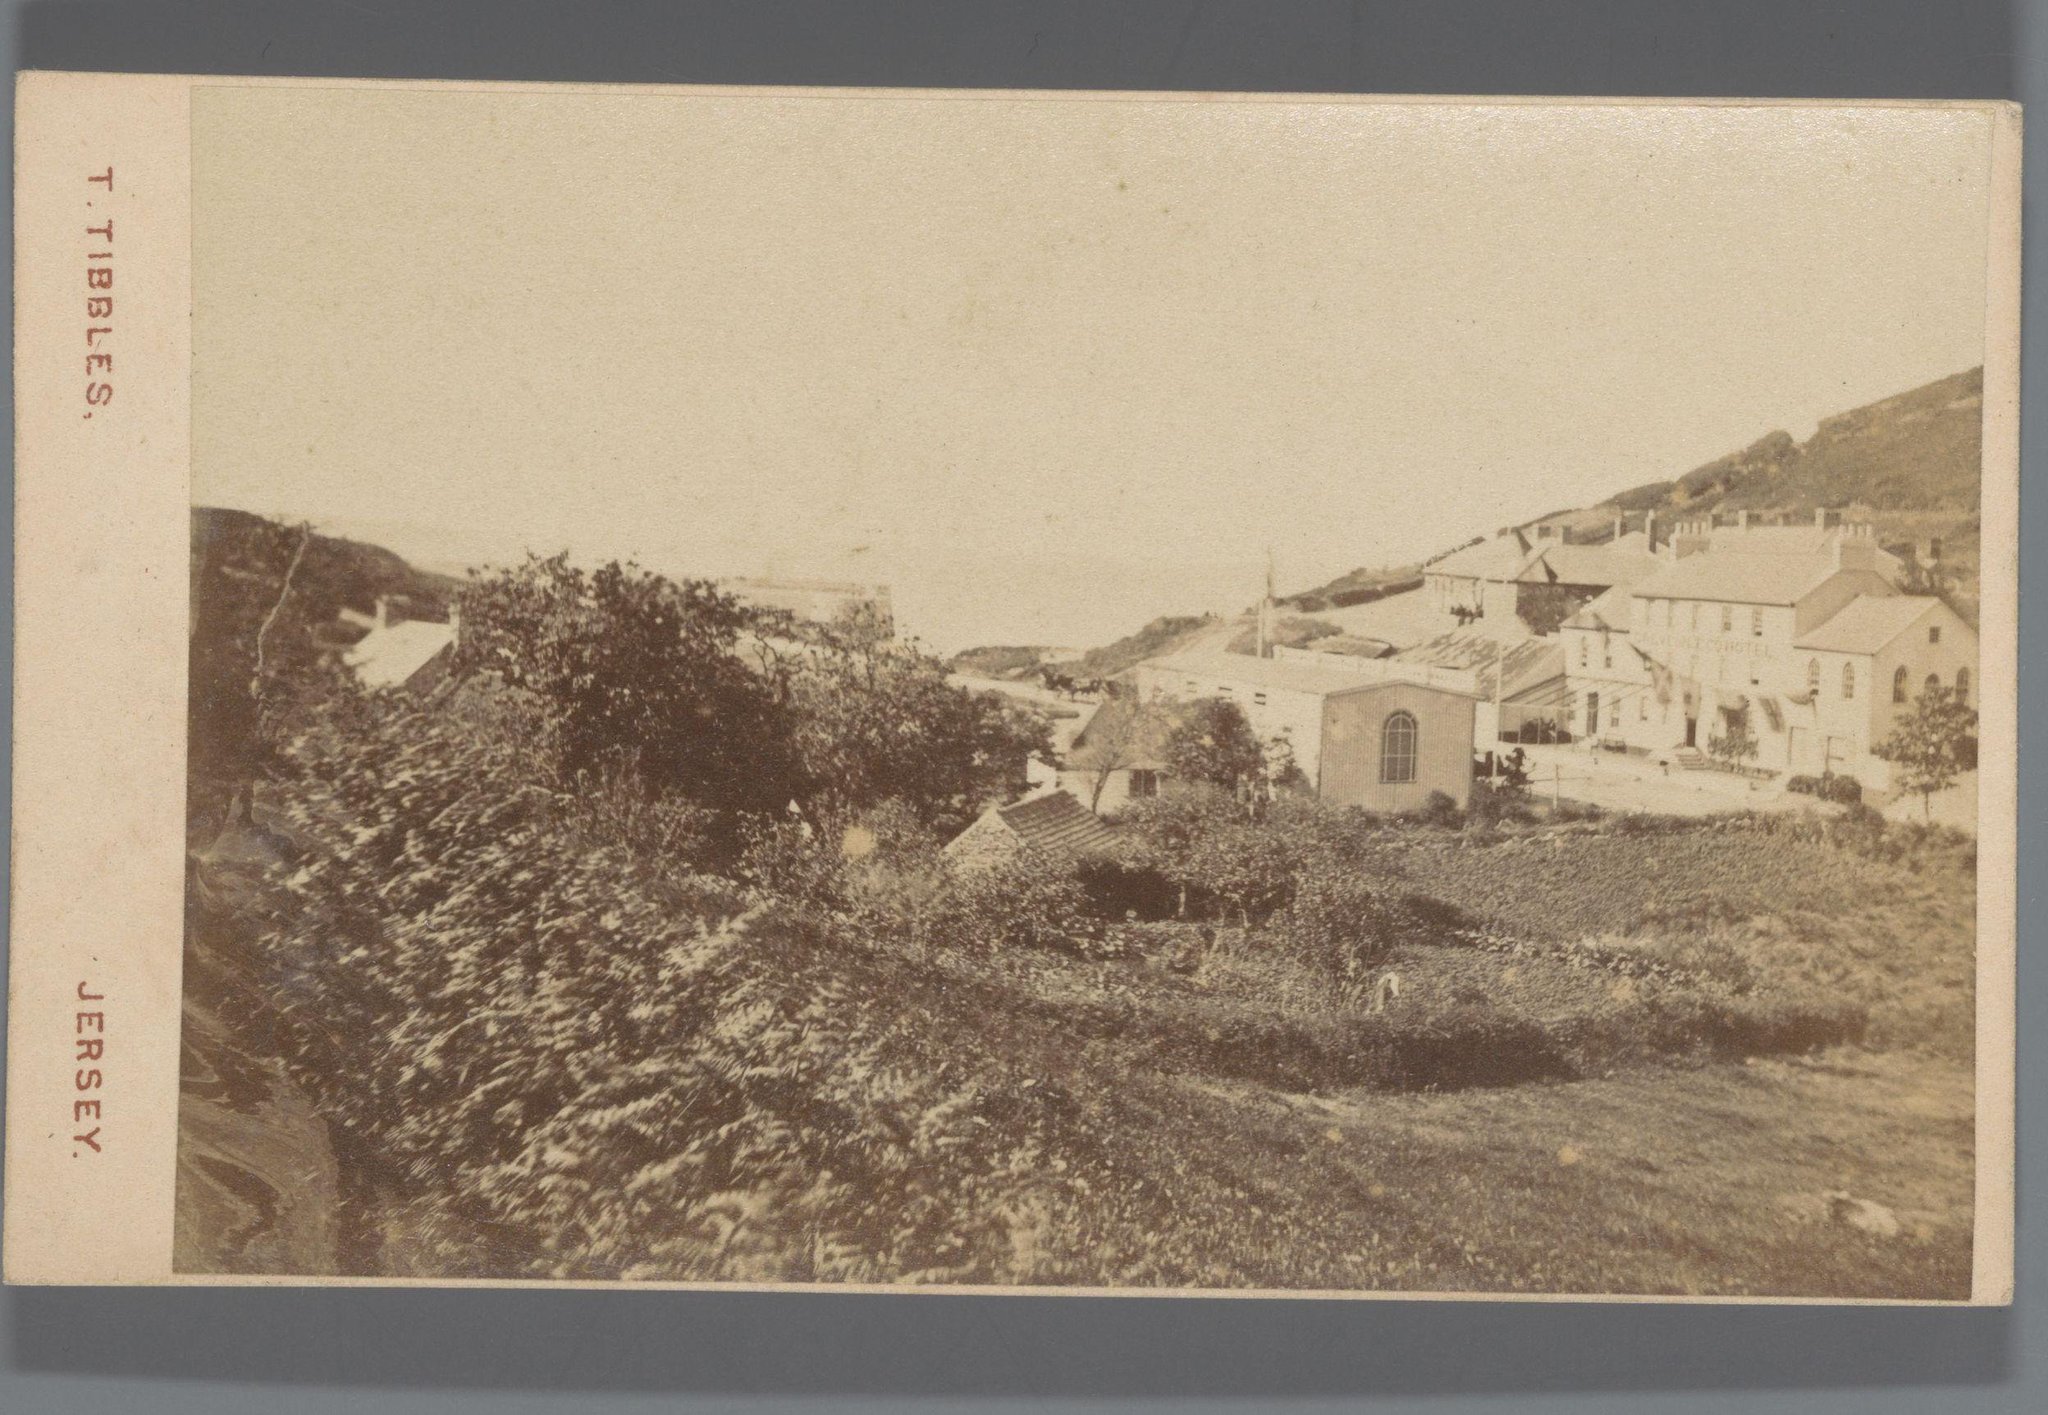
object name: carte de visite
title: Jersey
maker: thomas tibbles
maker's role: fotograaf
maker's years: -1885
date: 1871-1885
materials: cardboard, paper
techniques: albumen print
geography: jersey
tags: village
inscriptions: inscription: ‘The/ PIERSON PHOTOGRAPHIC STUDIO./ T. TIBLLES,/ PHOTOGRAPHER,/ 5, KING STREET,/ and Pierson Place,/ JERSEY./ Copies may always be obtaned.’